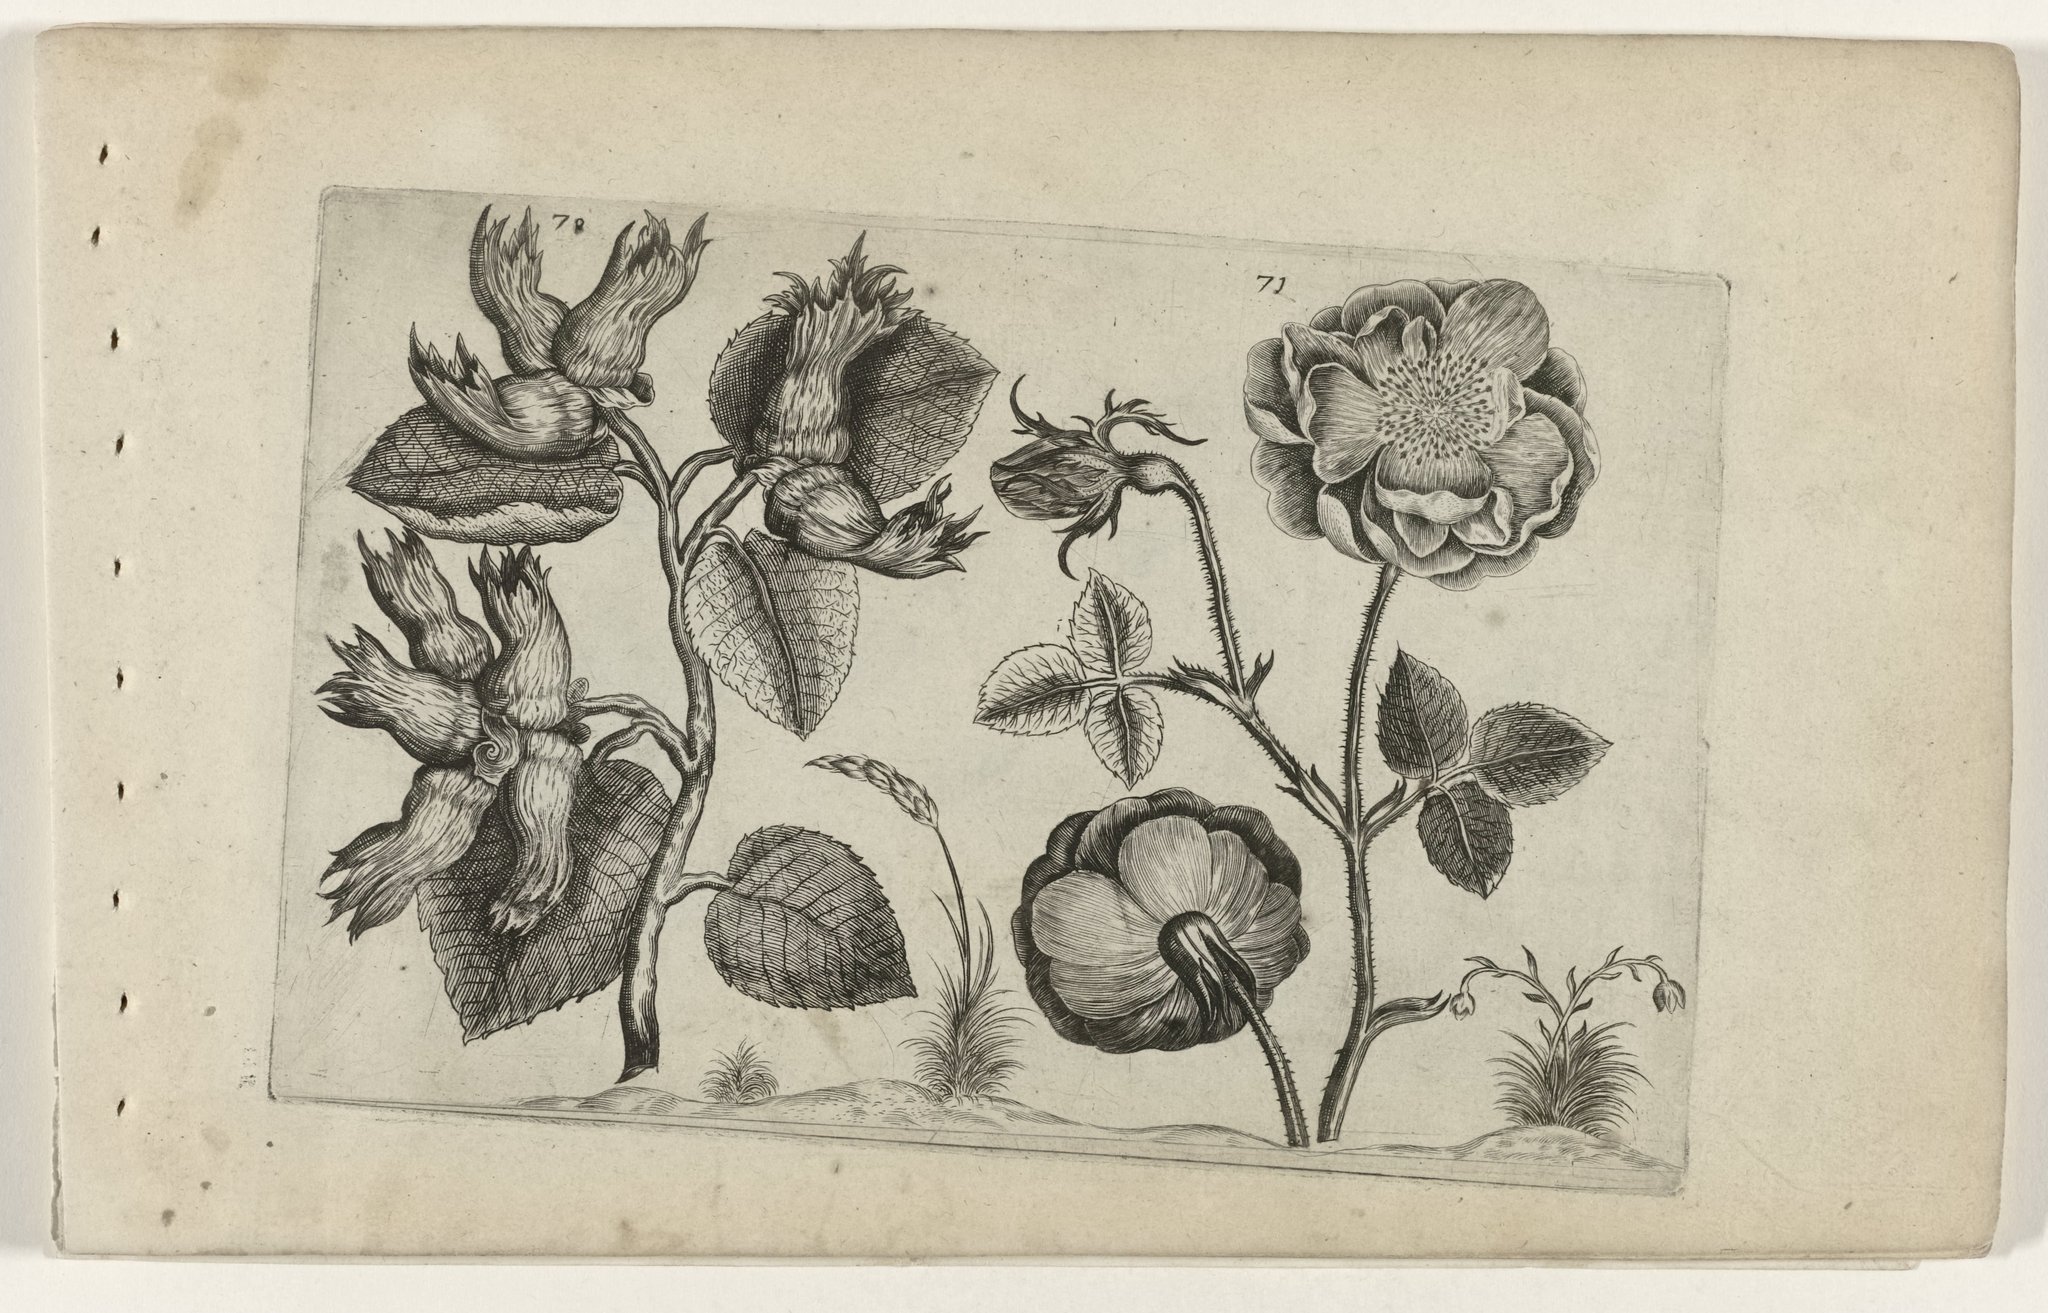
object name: album leaf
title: Hazelaar en roos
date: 1600-1604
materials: paper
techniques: engraving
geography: london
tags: flowers: rose, fruits: hazelnut, botany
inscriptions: collector's mark: Lugt 2228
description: De prenten RP-P-2012-24-1 t/m 61 waren oorspronkelijk als serie samengebonden. De naaigaten op de bladen zijn nog zichtbaar. Het betreft de reeks getiteld: Cognoscite lilia, bestaande uit een titelprent en 60 gravures met 119 genummerde weergaven van planten, bloemen en vruchten, versierd met rinceaux en kleine voorstellingen van dieren. Het gaat om proefdrukken van deze reeks gravures, voor de opschriften en, deels, voor de nummering. Op enkele prenten zijn de nummers met de hand aangebracht. Op de titelprent ontbreekt nog het adres van Crispijn de Passe en Hans Woutneel. De titel is hoogstwaarschijnlijk gegraveerd door Matthias Quad. Deze werkte voor De Passe in Keulen tot 1604. De reeks moet in dit jaar of daarvoor tot stand zijn gebracht. In ieder geval voor 1608, aangezien de uitgever Hans Woutneel in of voor dat jaar overleed. In ieder geval voor 1608, aangezien de uitgever Hans Woutneel in of voor dat jaar overleed. De gravures worden door Ilja Veldman en Anthony Griffiths beschouwd als eigenhandig werk van Crispijn de Passe I. Een van de prenten uit de reeks ontbreekt (nr 21-22) en is vervangen door een ingekleurde afdruk uit een latere uitgave (RP-P-2012-24-61), die onder de titel Altera Pars is opgenomen in de Hortus Floridus, uitgegeven door Crispijn de Passe I en die verder bestaat uit platen van Crispijn de Passe II. De prenten afkomstig uit deze uitgave zijn op de verso voorzien van tekst in boekdruk. De vervangende prent maakte geen deel uit van de gebonden serie aangezien dit blad als enige geen naaigaten heeft. Een deel van de planten, bloemen en vruchten in de Cognoscite lilia gaat terug of is gebaseerd op een reeks aquarellen van Jacques LeMoyne uit circa 1580 en uit 1585, nu in het Victoria and Albert Museum en de British Museum (zie P. Hulton, Jacques LeMoyne, Londen 1977, dl 1, p. 156-162 en p. 165-173).